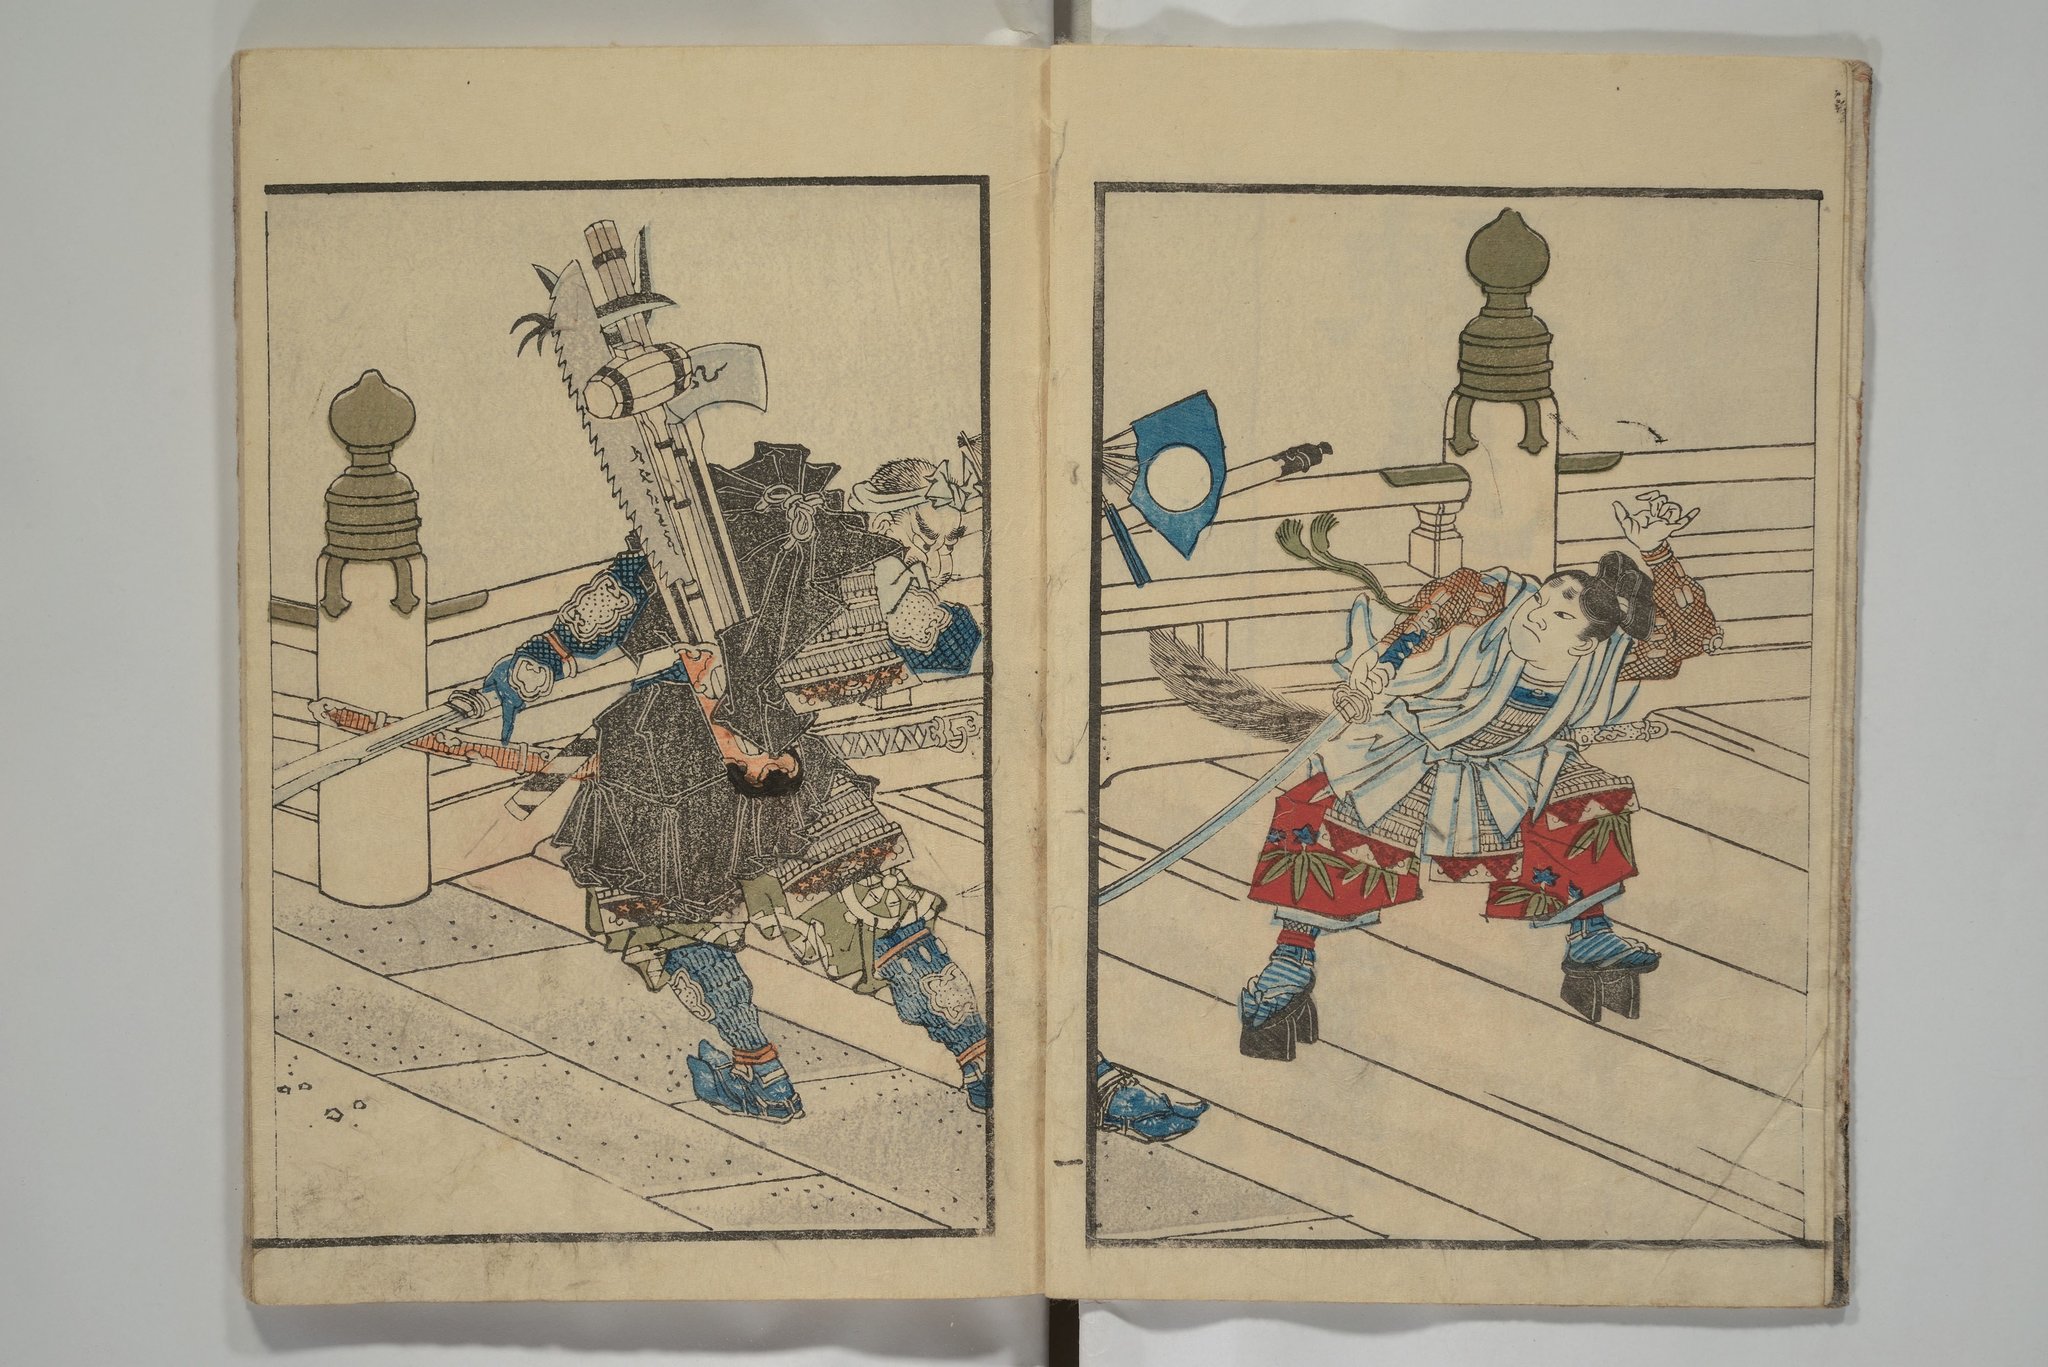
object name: illustrated book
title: Festival Lanterns, First Series (Shinji andon shohen) 神事行燈 初編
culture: japanese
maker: ōishi matora 大石真虎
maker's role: artist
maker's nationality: japanese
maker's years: 1793-1833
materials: ink, paper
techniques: woodblock print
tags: swords,men